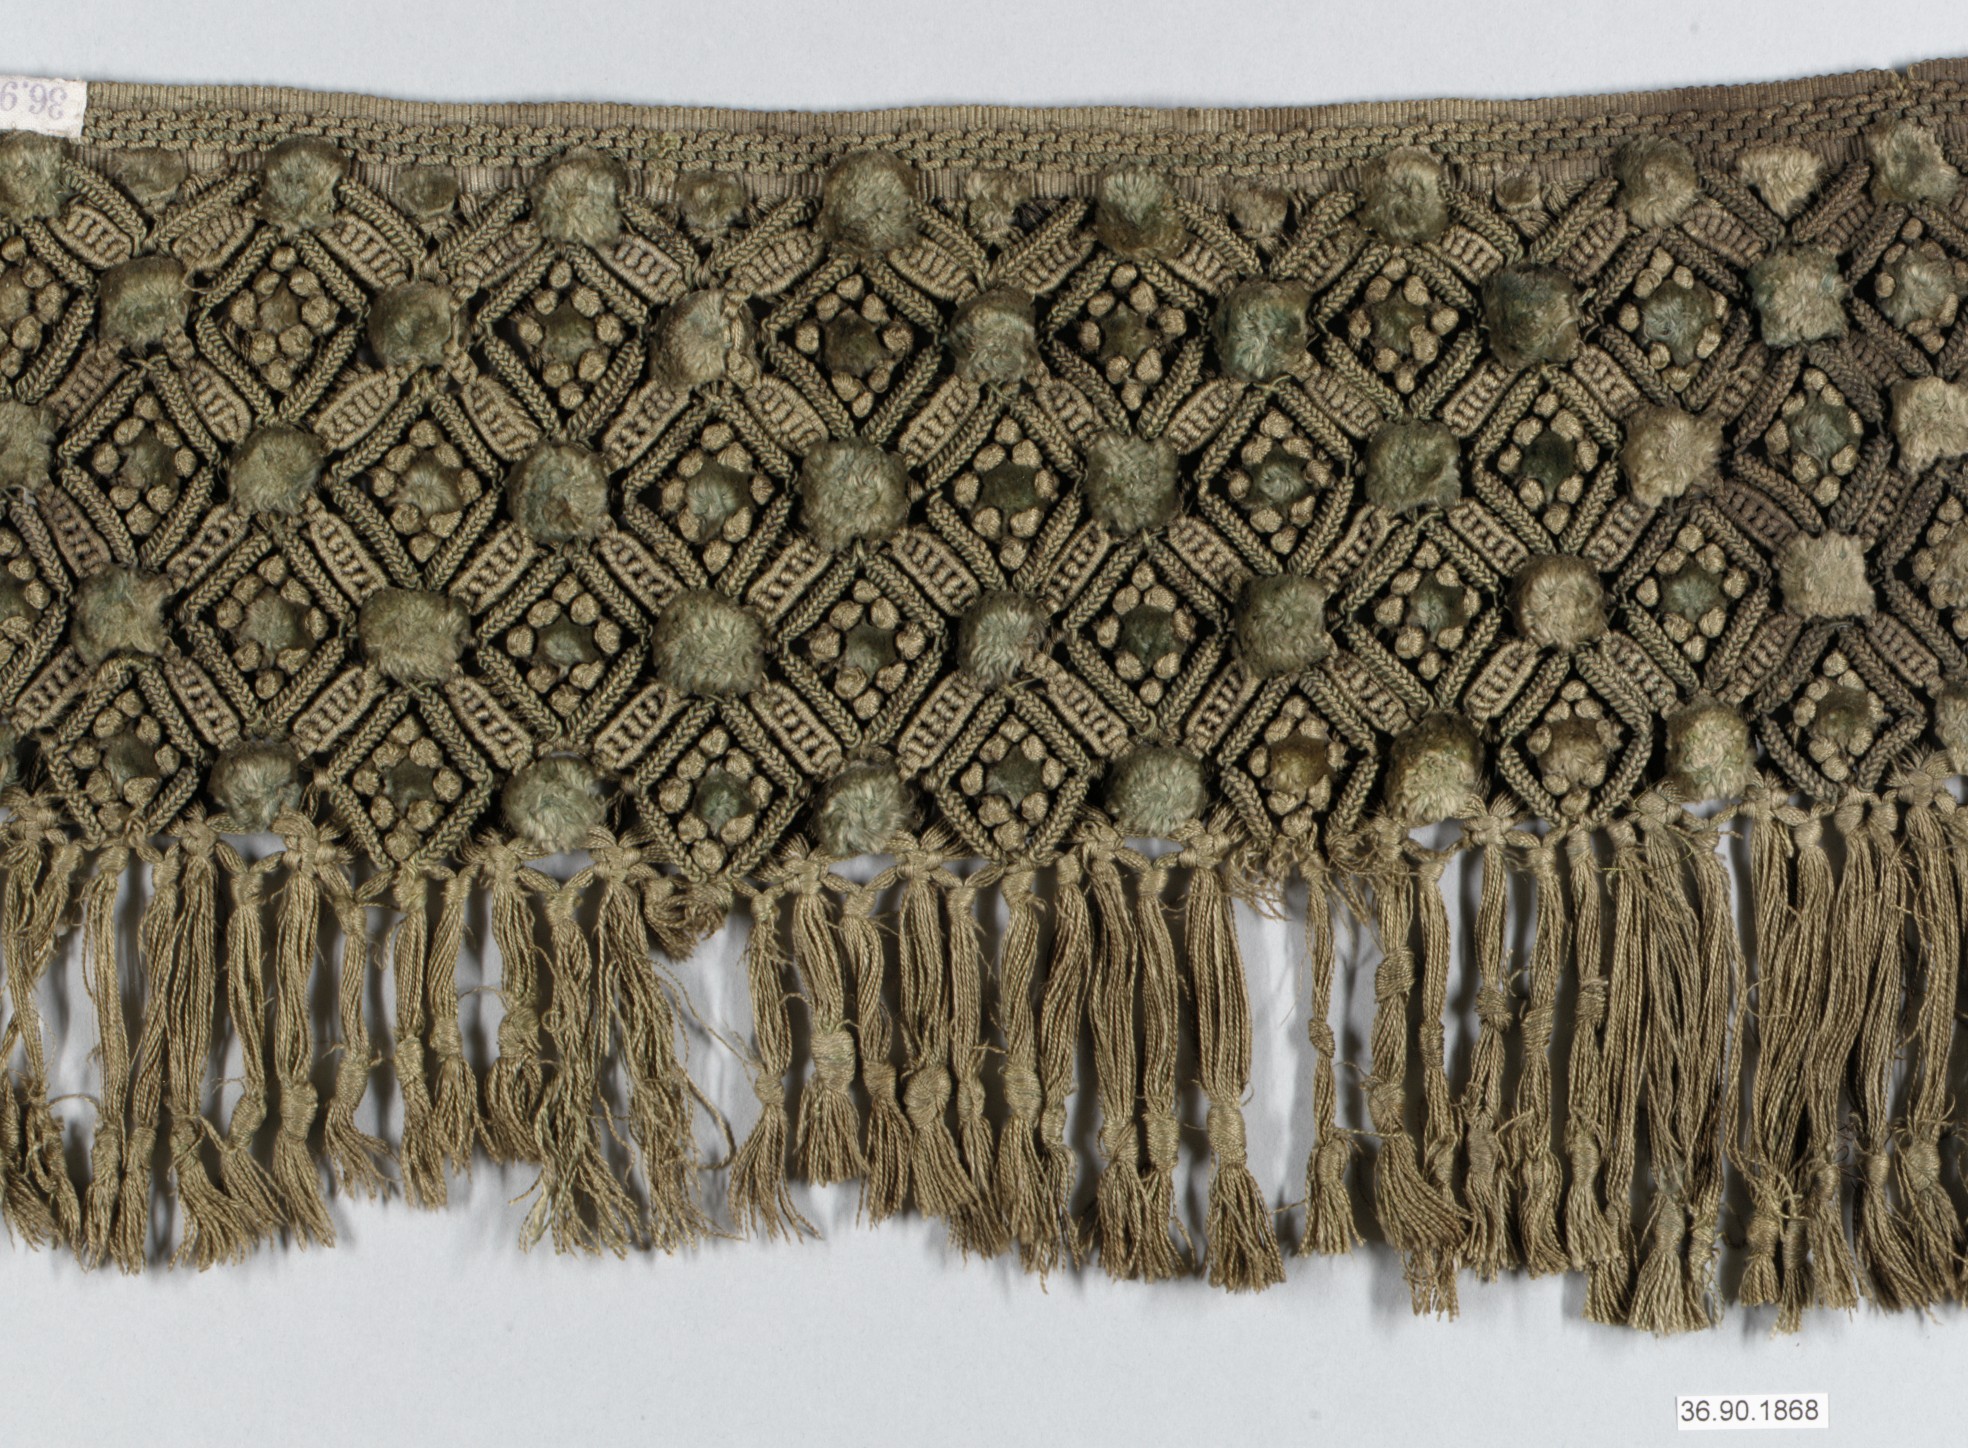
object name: fringe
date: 1801-1900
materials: silk